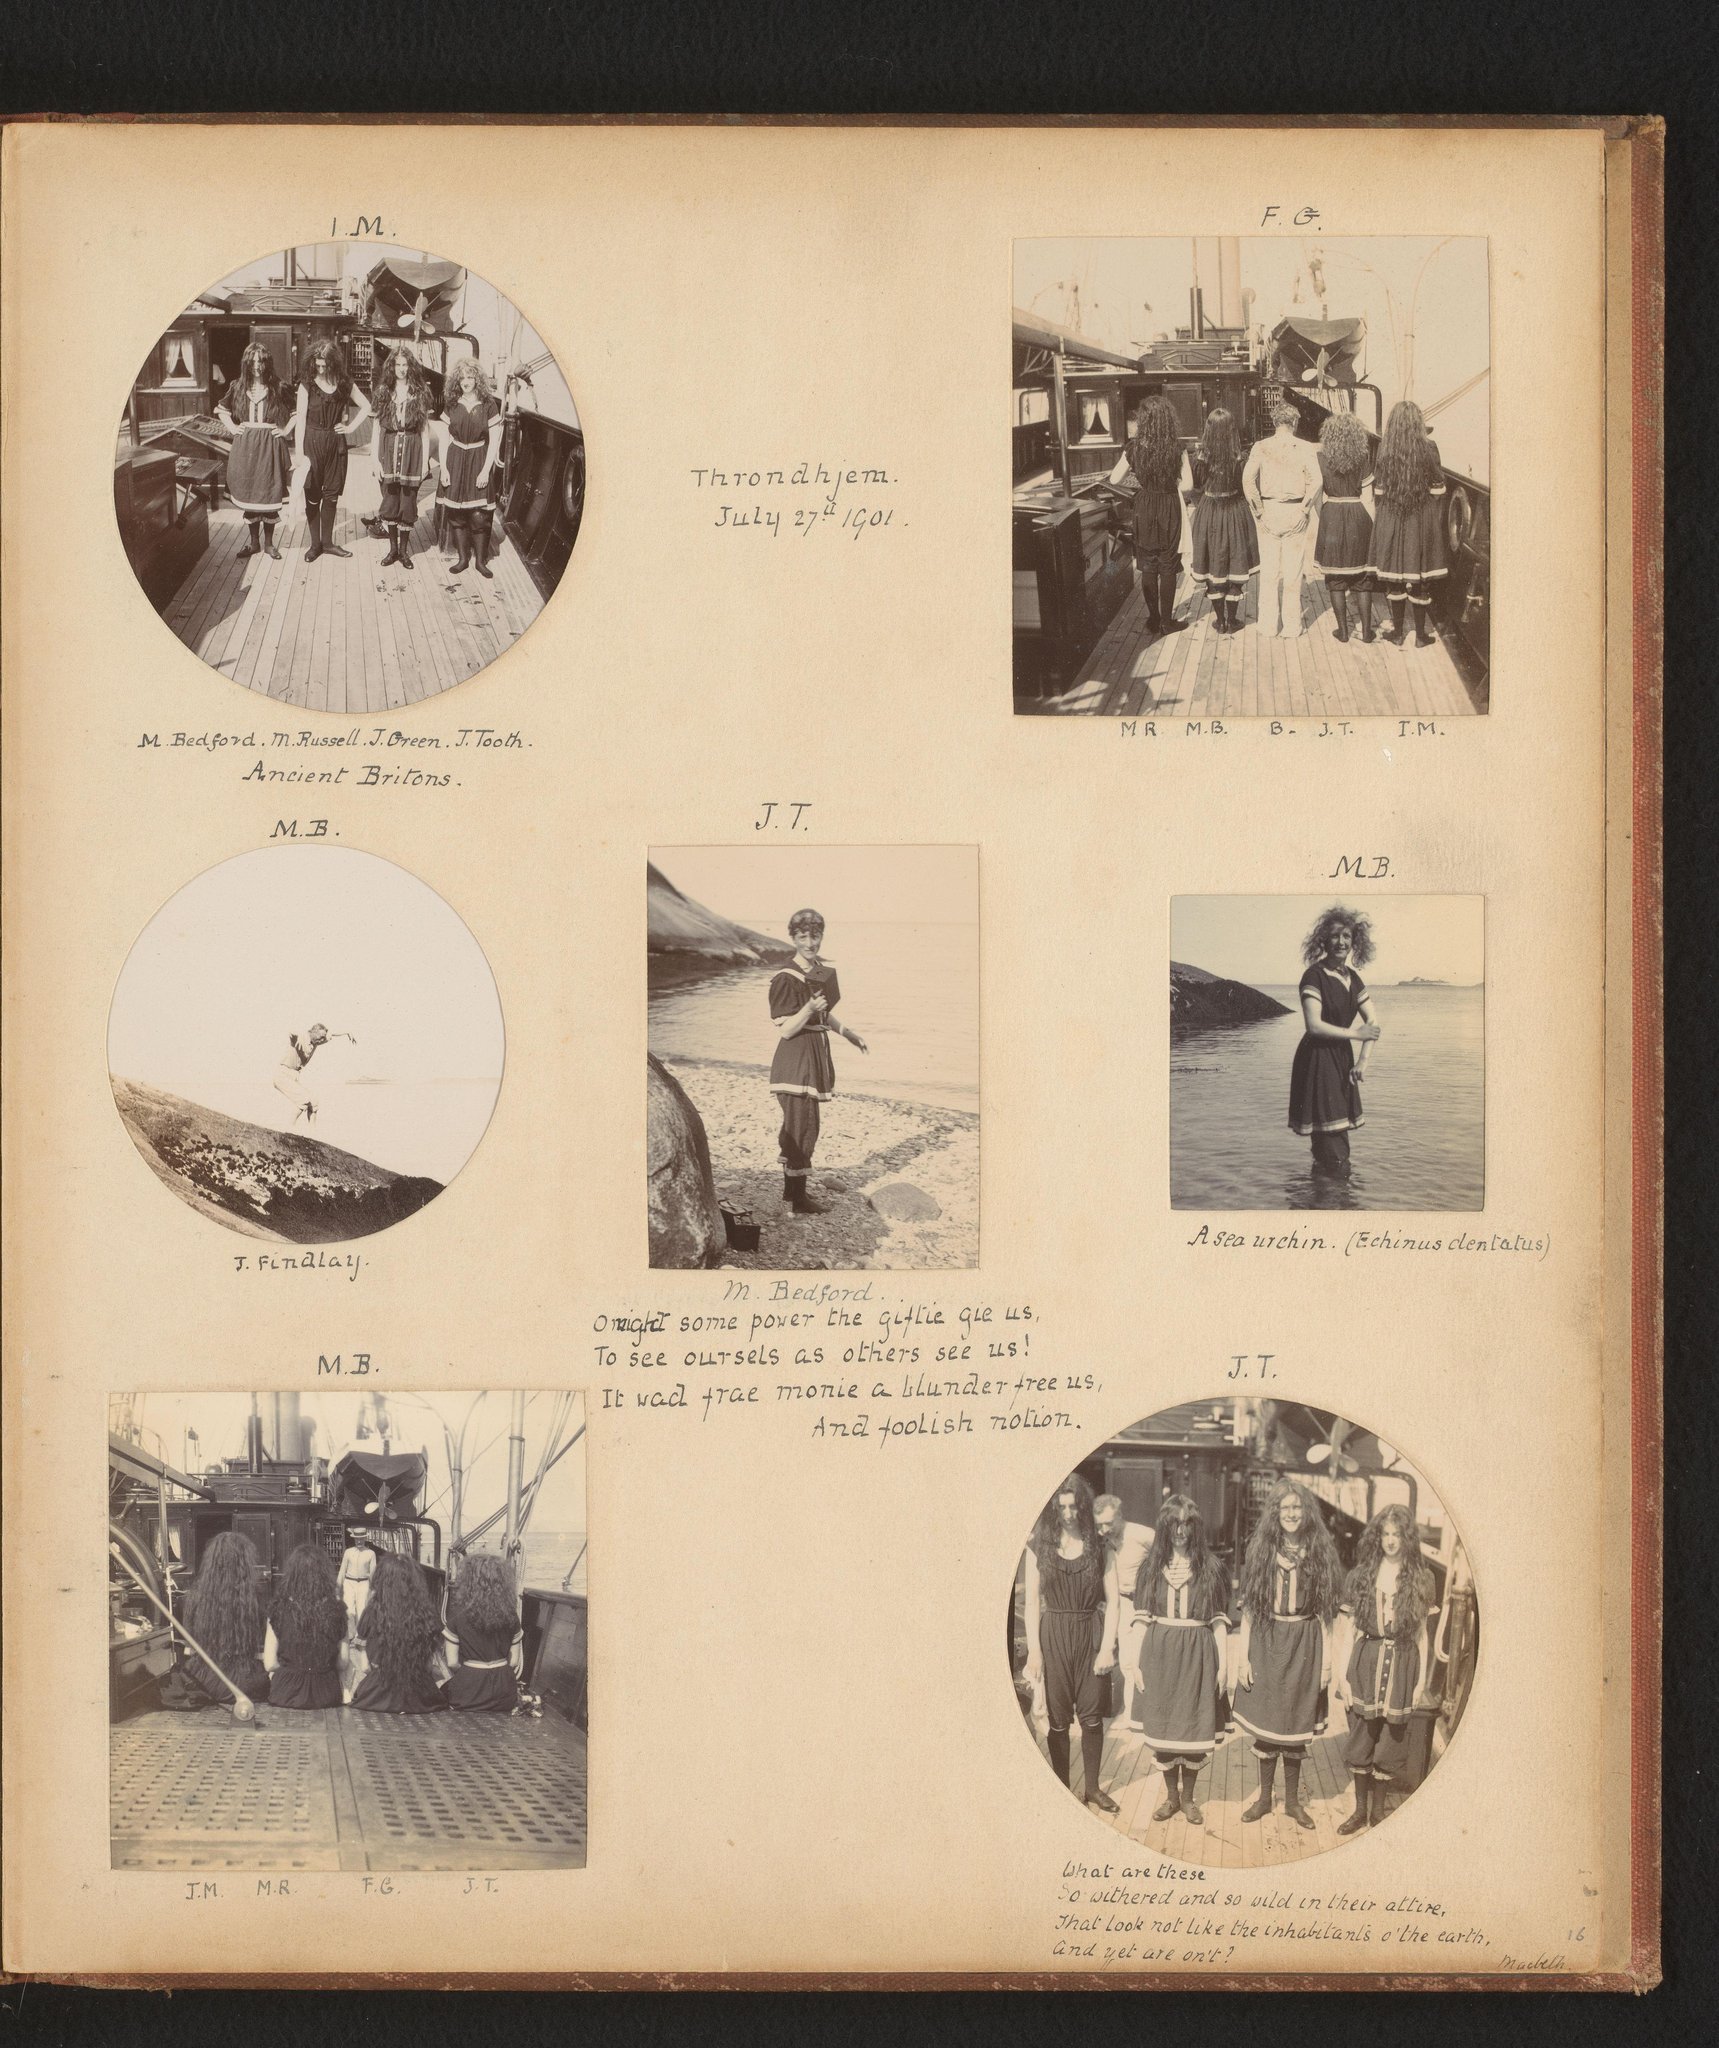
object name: album leaf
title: Zeven foto's van het reisgezelschap op het strand en op het schip S.Y. Sapphire, Trondheim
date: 1901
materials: paper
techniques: gelatin silver print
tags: j. tooth, f. green (fotograaf), duchess of bedford, i. marshall, mary russell, beach (as place of recreation), dress-up party, camera ~ photography, historical costume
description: Deze foto's maken deel uit van een album.